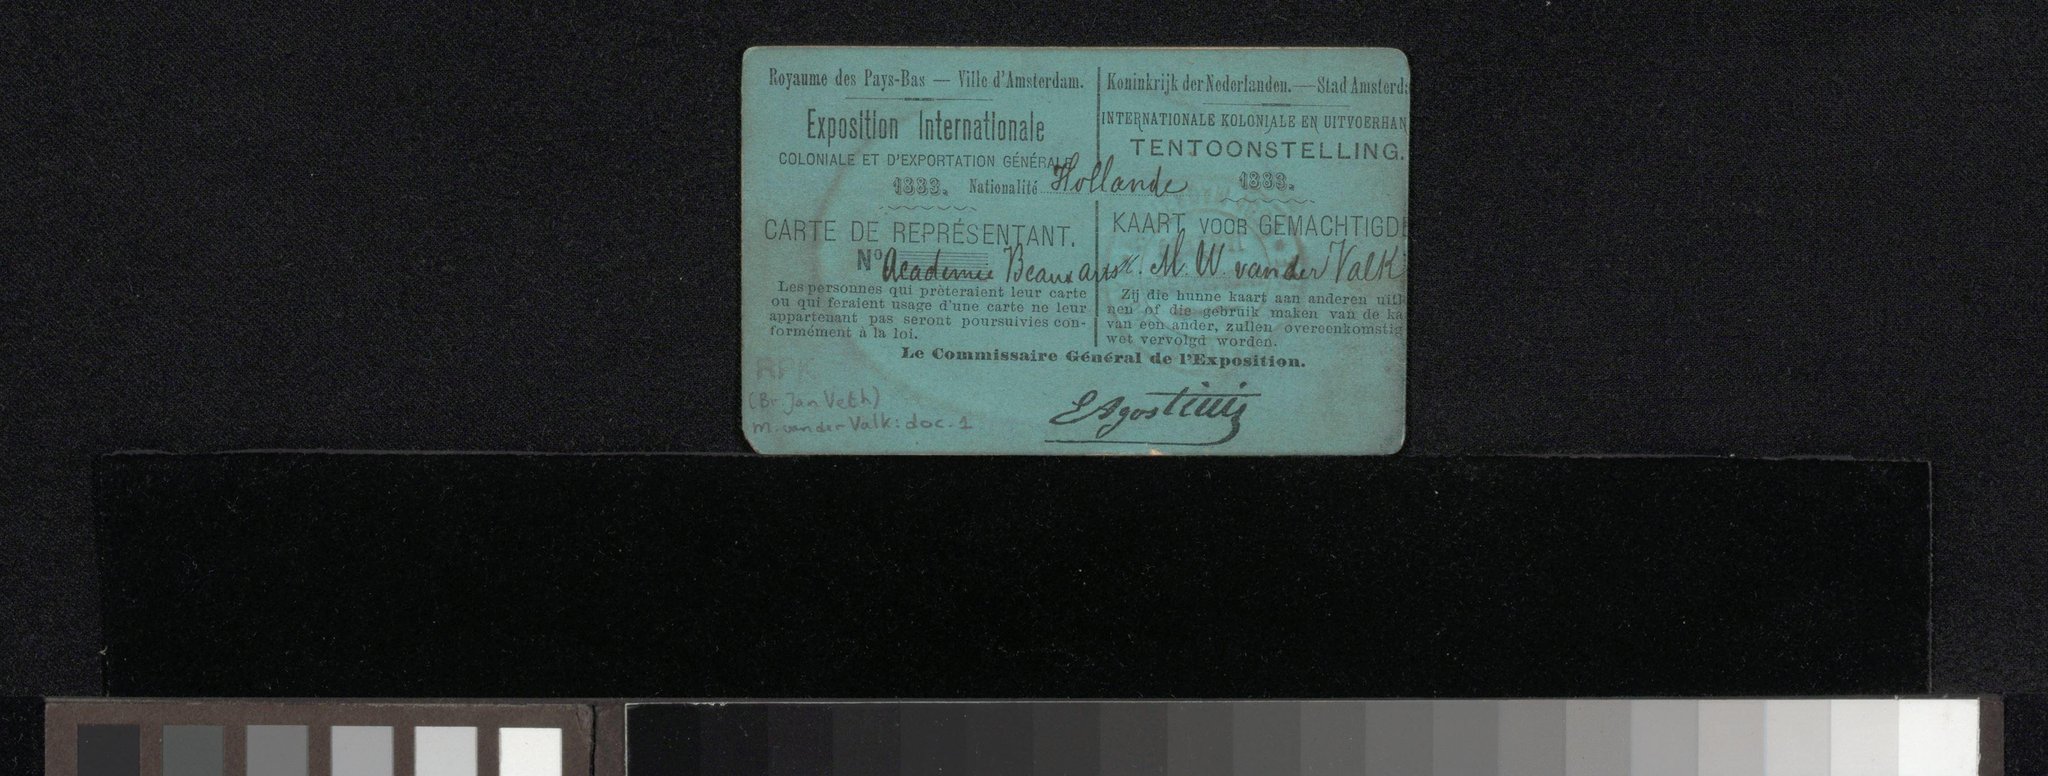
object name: admission ticket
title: Toegangskaart uit archief Jan Veth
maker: Anonymous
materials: cardboard, ink, photographic support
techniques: albumen print, pen, writing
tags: dordrecht, painter, print maker, draughtsman, designer, jan veth, maurits van der valk, historical persons (portraits and scenes from the life)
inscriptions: collector's mark: ‘RPK’, stamp: ‘EXPOSITION INTERNATIONALE/ AMSTERDAM, 1883’, check stamp: ‘EXPOSITION INTERNATIONALE AMSTERDAM/ [?]’